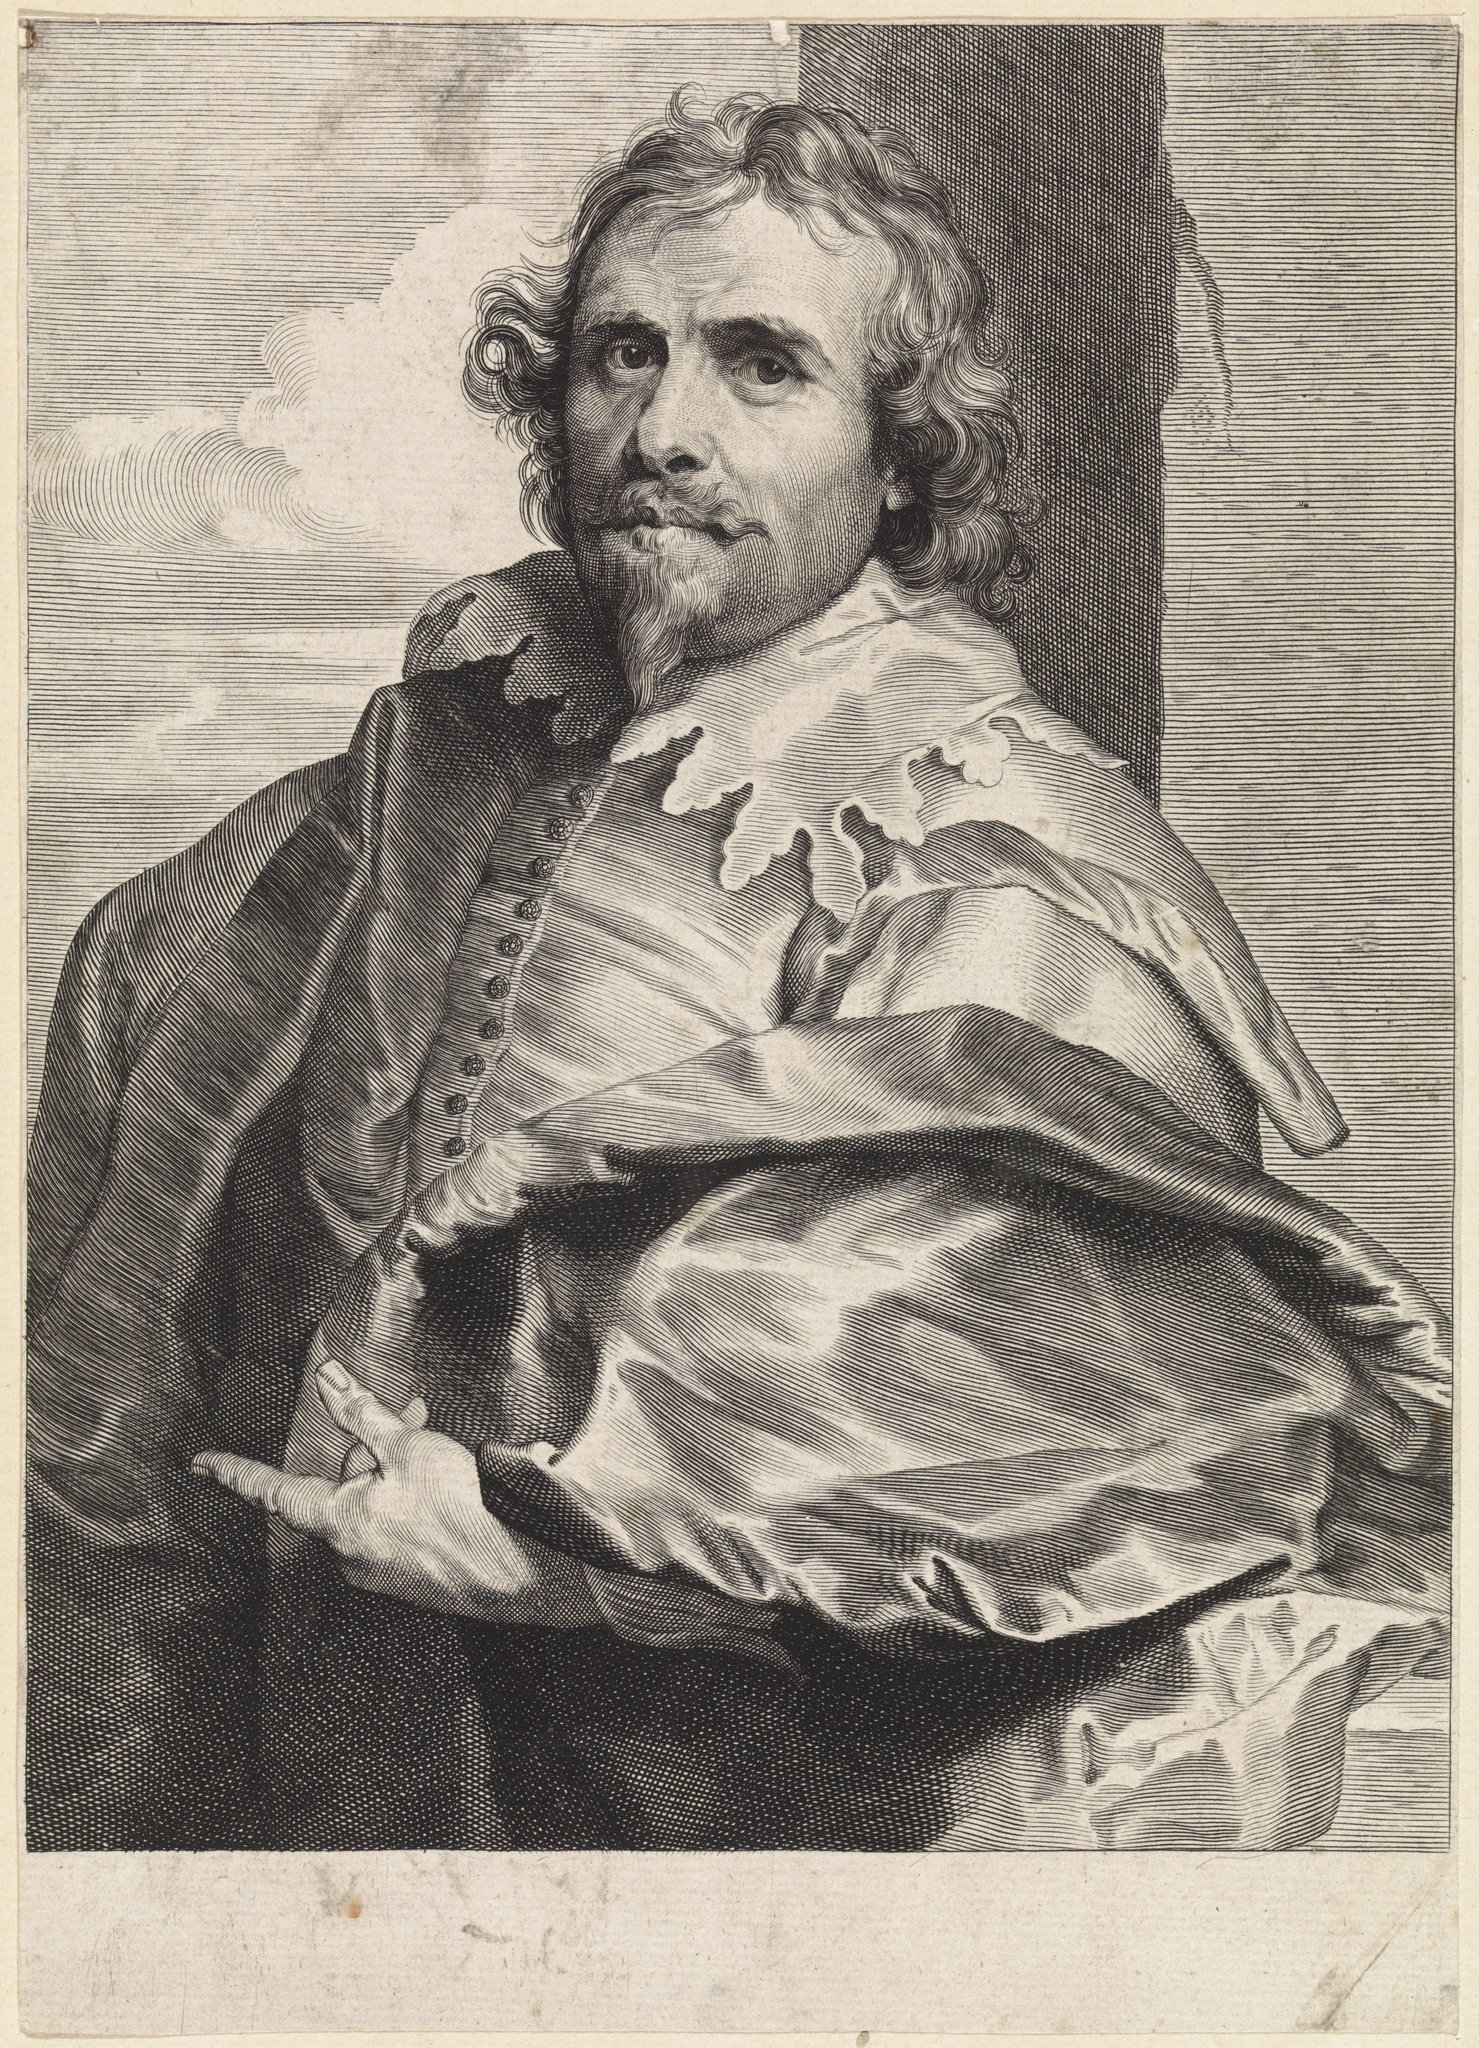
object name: print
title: Portret van de schilder Daniël Mijtens (I)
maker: paulus pontius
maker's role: draughtsman, print maker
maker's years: 1603-1658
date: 1616-1657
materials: paper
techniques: engraving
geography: antwerp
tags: delft, painter, daniël mijtens (i), portrait, self-portrait of painter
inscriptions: collector's mark: Lugt 240